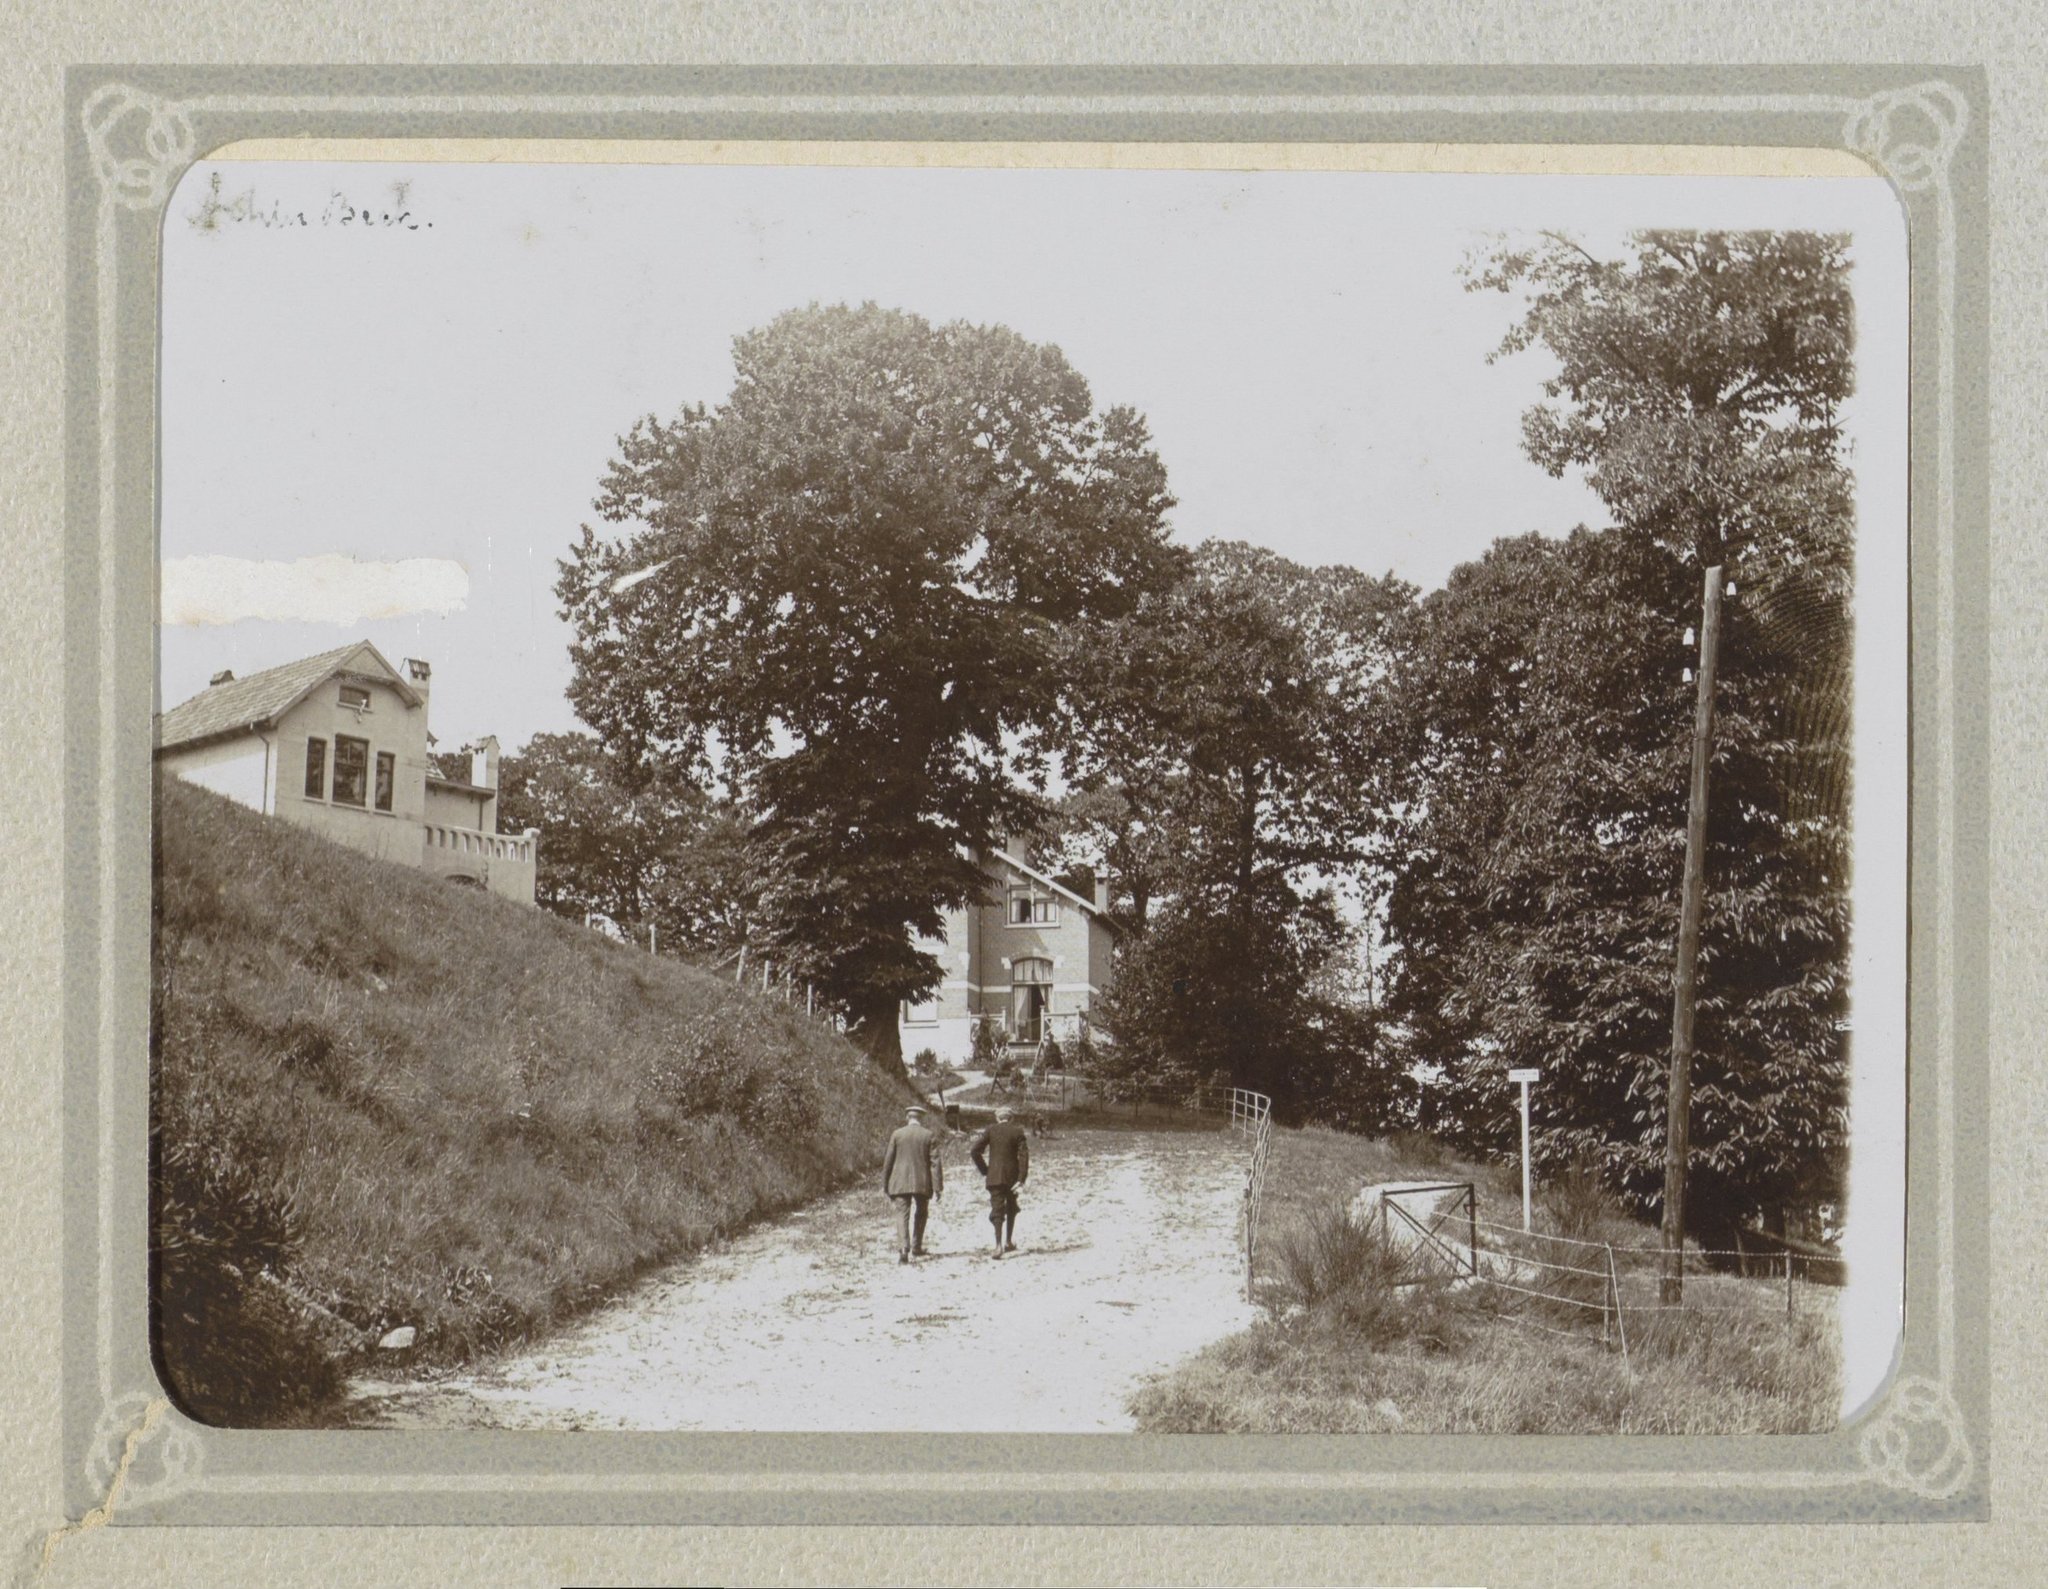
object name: photograph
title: [(...)] Beek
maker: folkert idzes de jong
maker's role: architect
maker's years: 1877-1929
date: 1905-1907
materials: photographic support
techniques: collodion silver print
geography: beek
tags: rural housing, e.g. country-house, villa, cottage, public road in village, walking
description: Onderdeel van Topografisch album van Nederlandse dorpen en steden 1905.